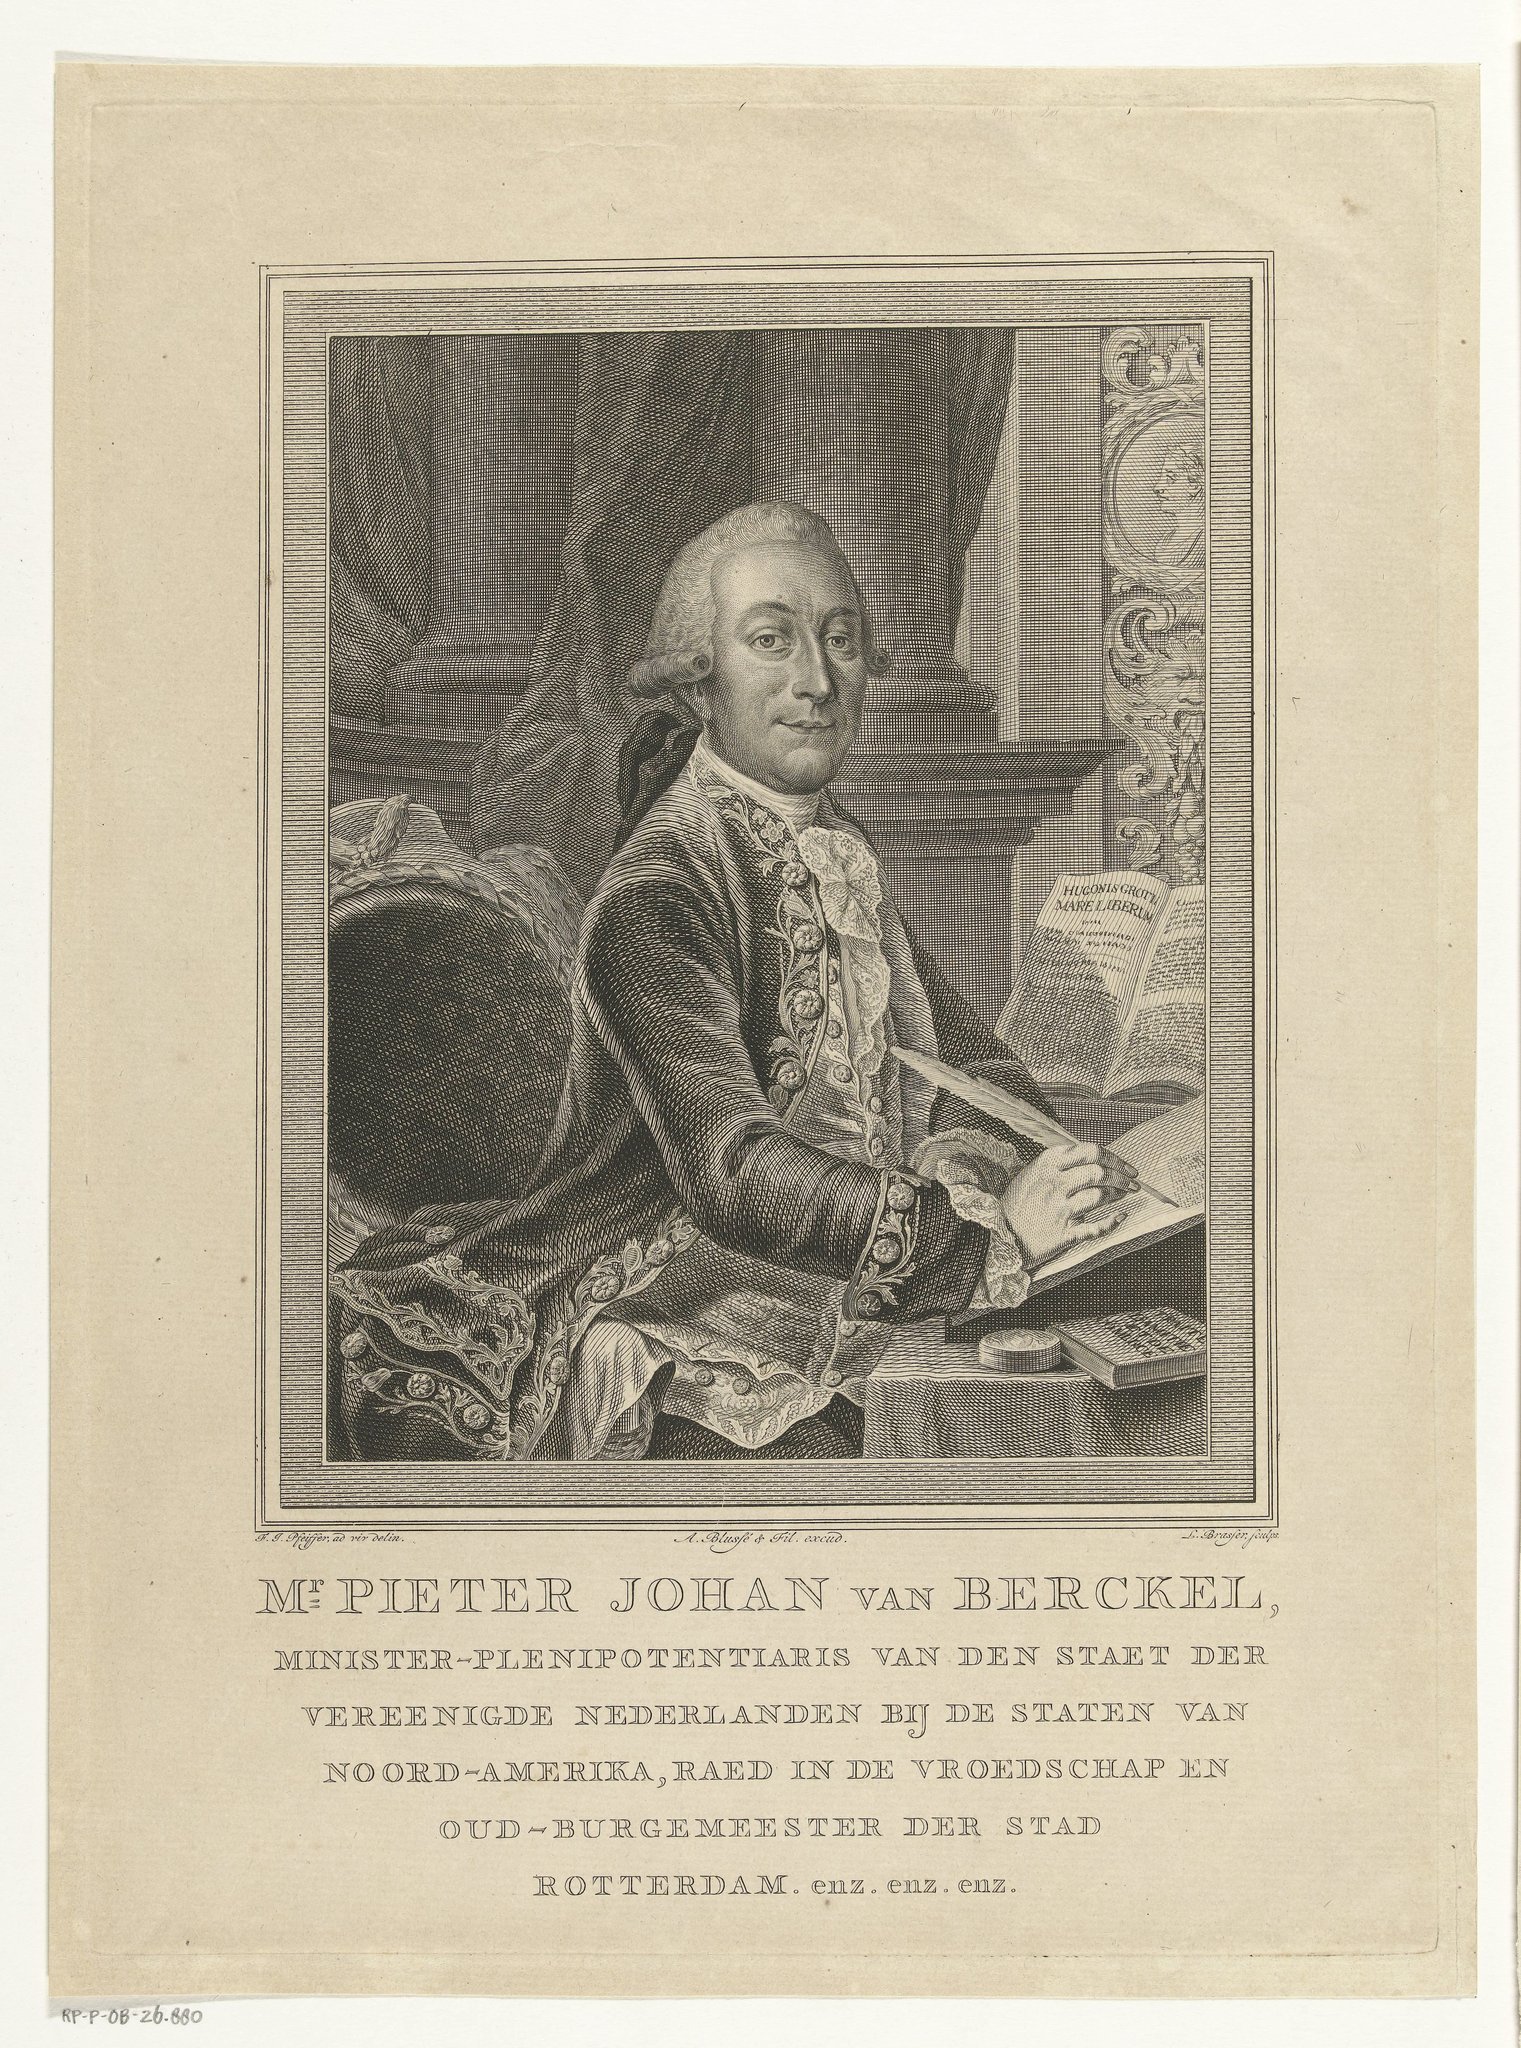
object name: print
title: Mr. Pieter Johan van Berckel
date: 1780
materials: paper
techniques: engraving, etching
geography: netherlands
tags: newark, ambassadeur, pieter johan van berckel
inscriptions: collector's mark: Lugt 2228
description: Prent naar tekening van Francois Joseph Pfeiffer. De tekening met het portret dateert uit 1780 aldus het Nieuw Nederlands Biografisch woordenboek, dl. 2, p. 128, 129.